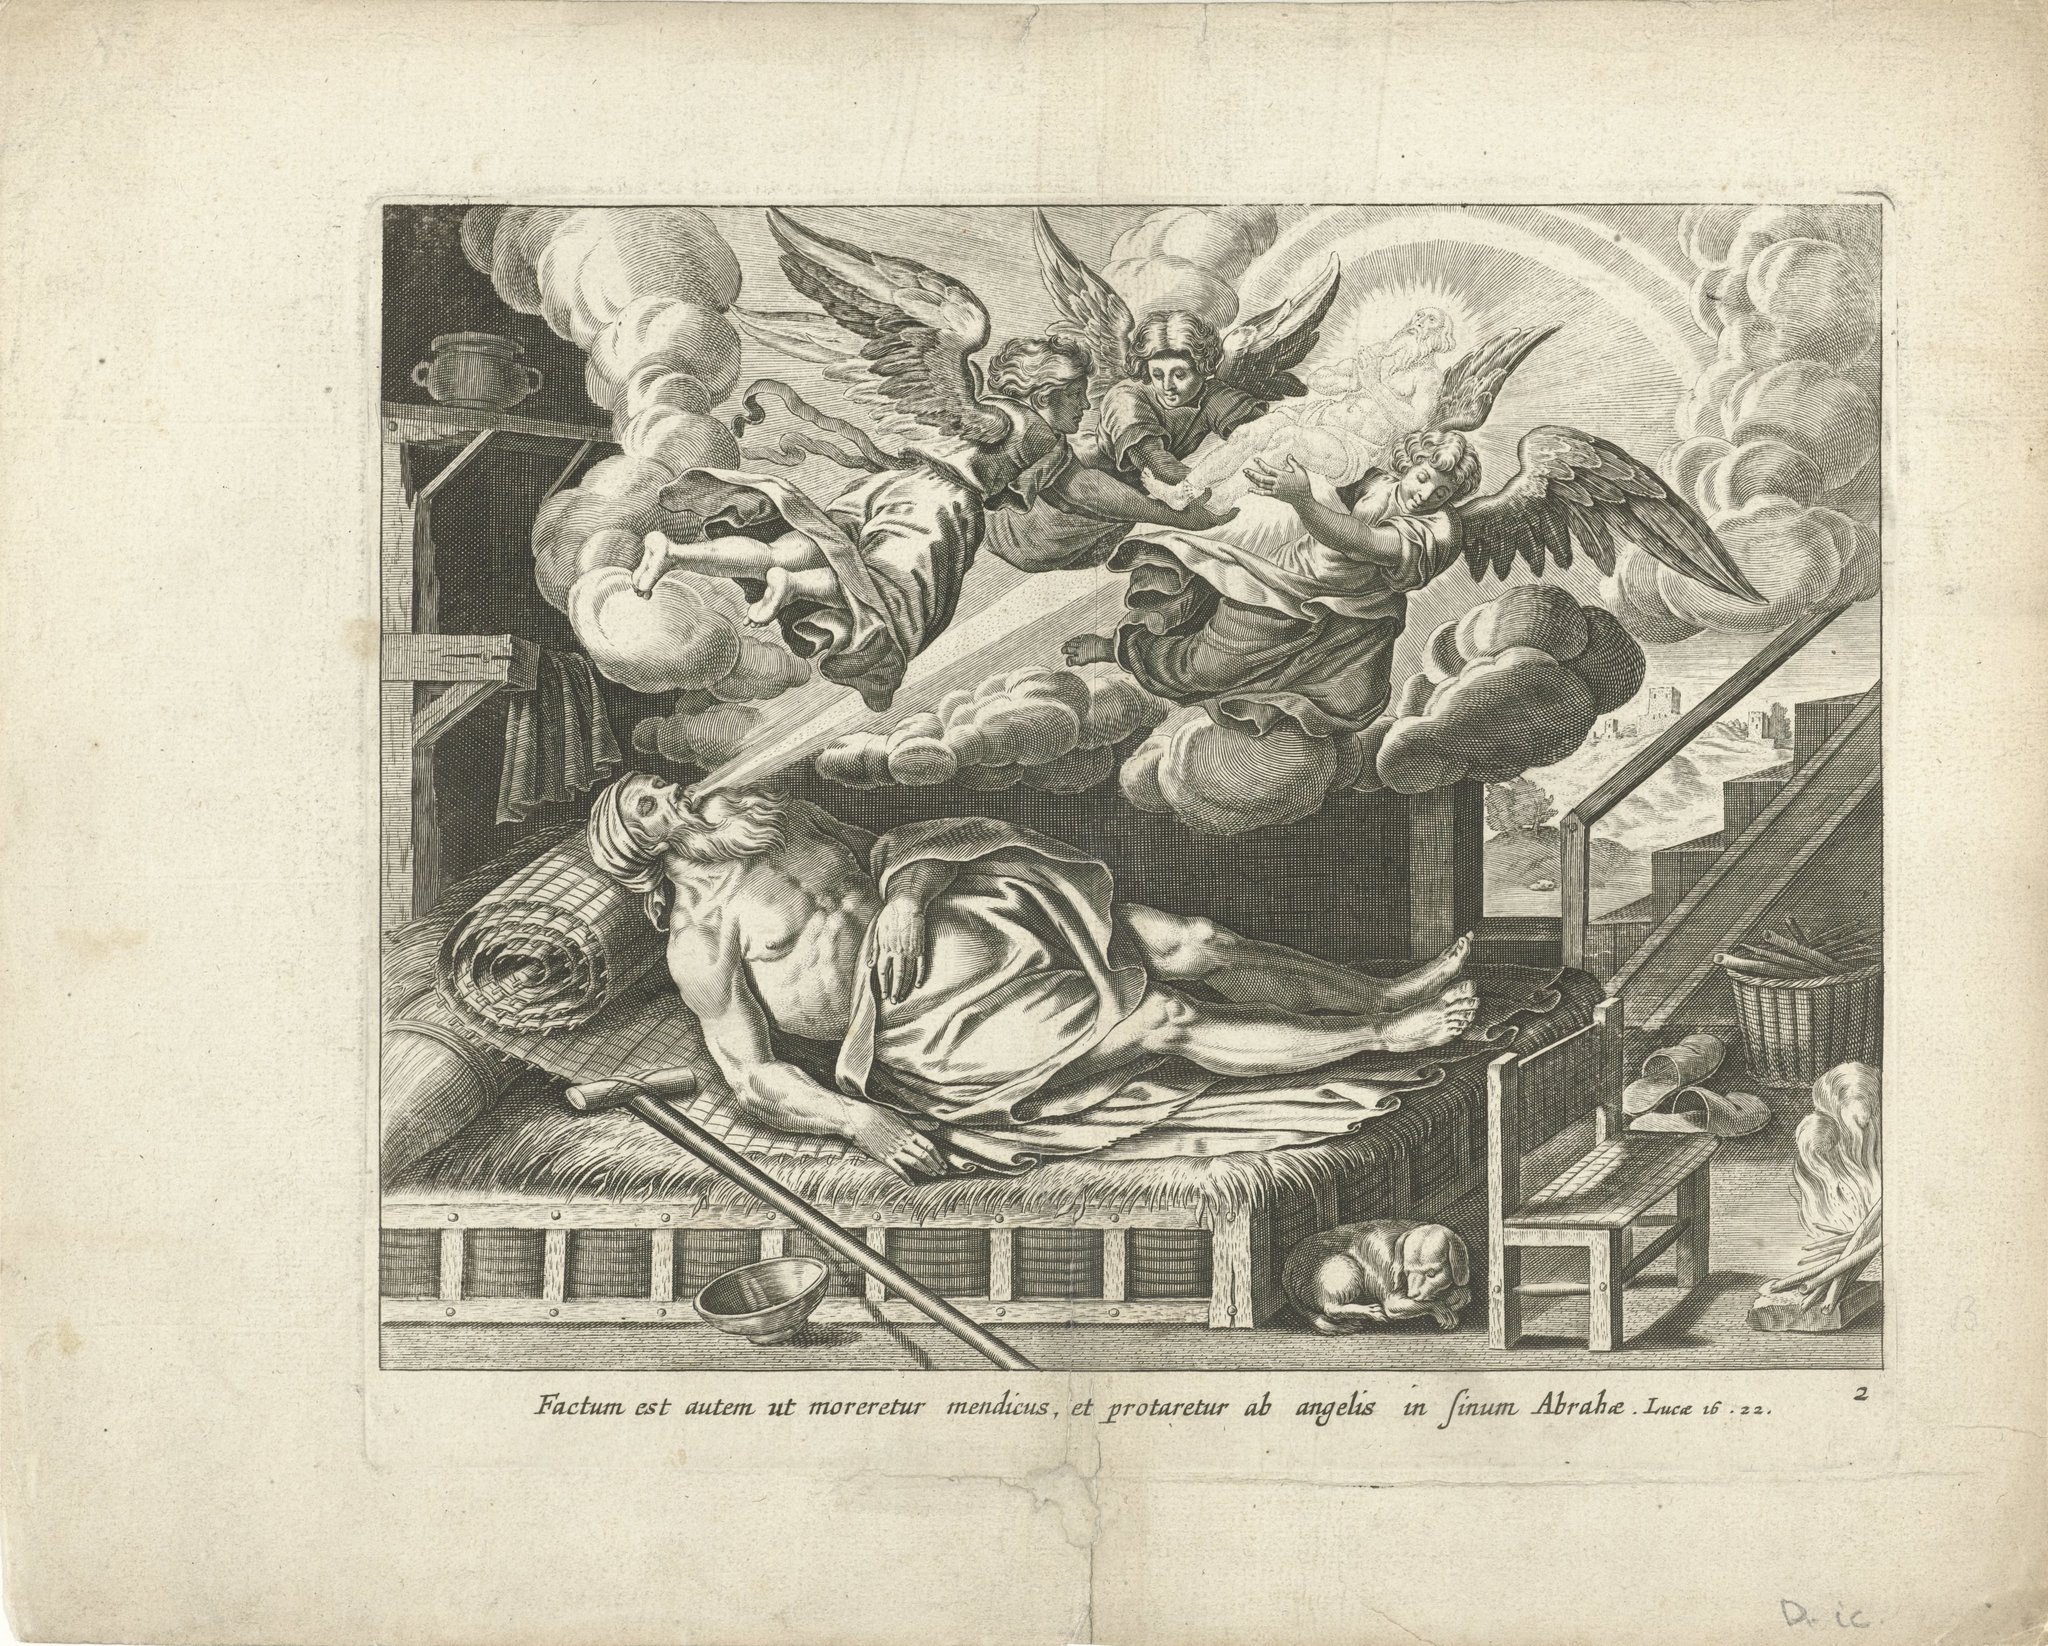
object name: print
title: Gelijkenis van de rijke man en de arme Lazarus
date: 1601-1652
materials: paper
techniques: engraving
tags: lazarus dies: his soul is carried into abraham's lap by angels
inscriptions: collector's mark: Lugt 2228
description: Lazarus ligt op een strobed en blaast zijn laaste adem uit. In de lucht drie engelen die de arme Lazarus naar de hemel voeren. De prent heeft een Latijns opschrift en maakt deel uit van een serie over gelijkenis van de rijke man en Lazarus